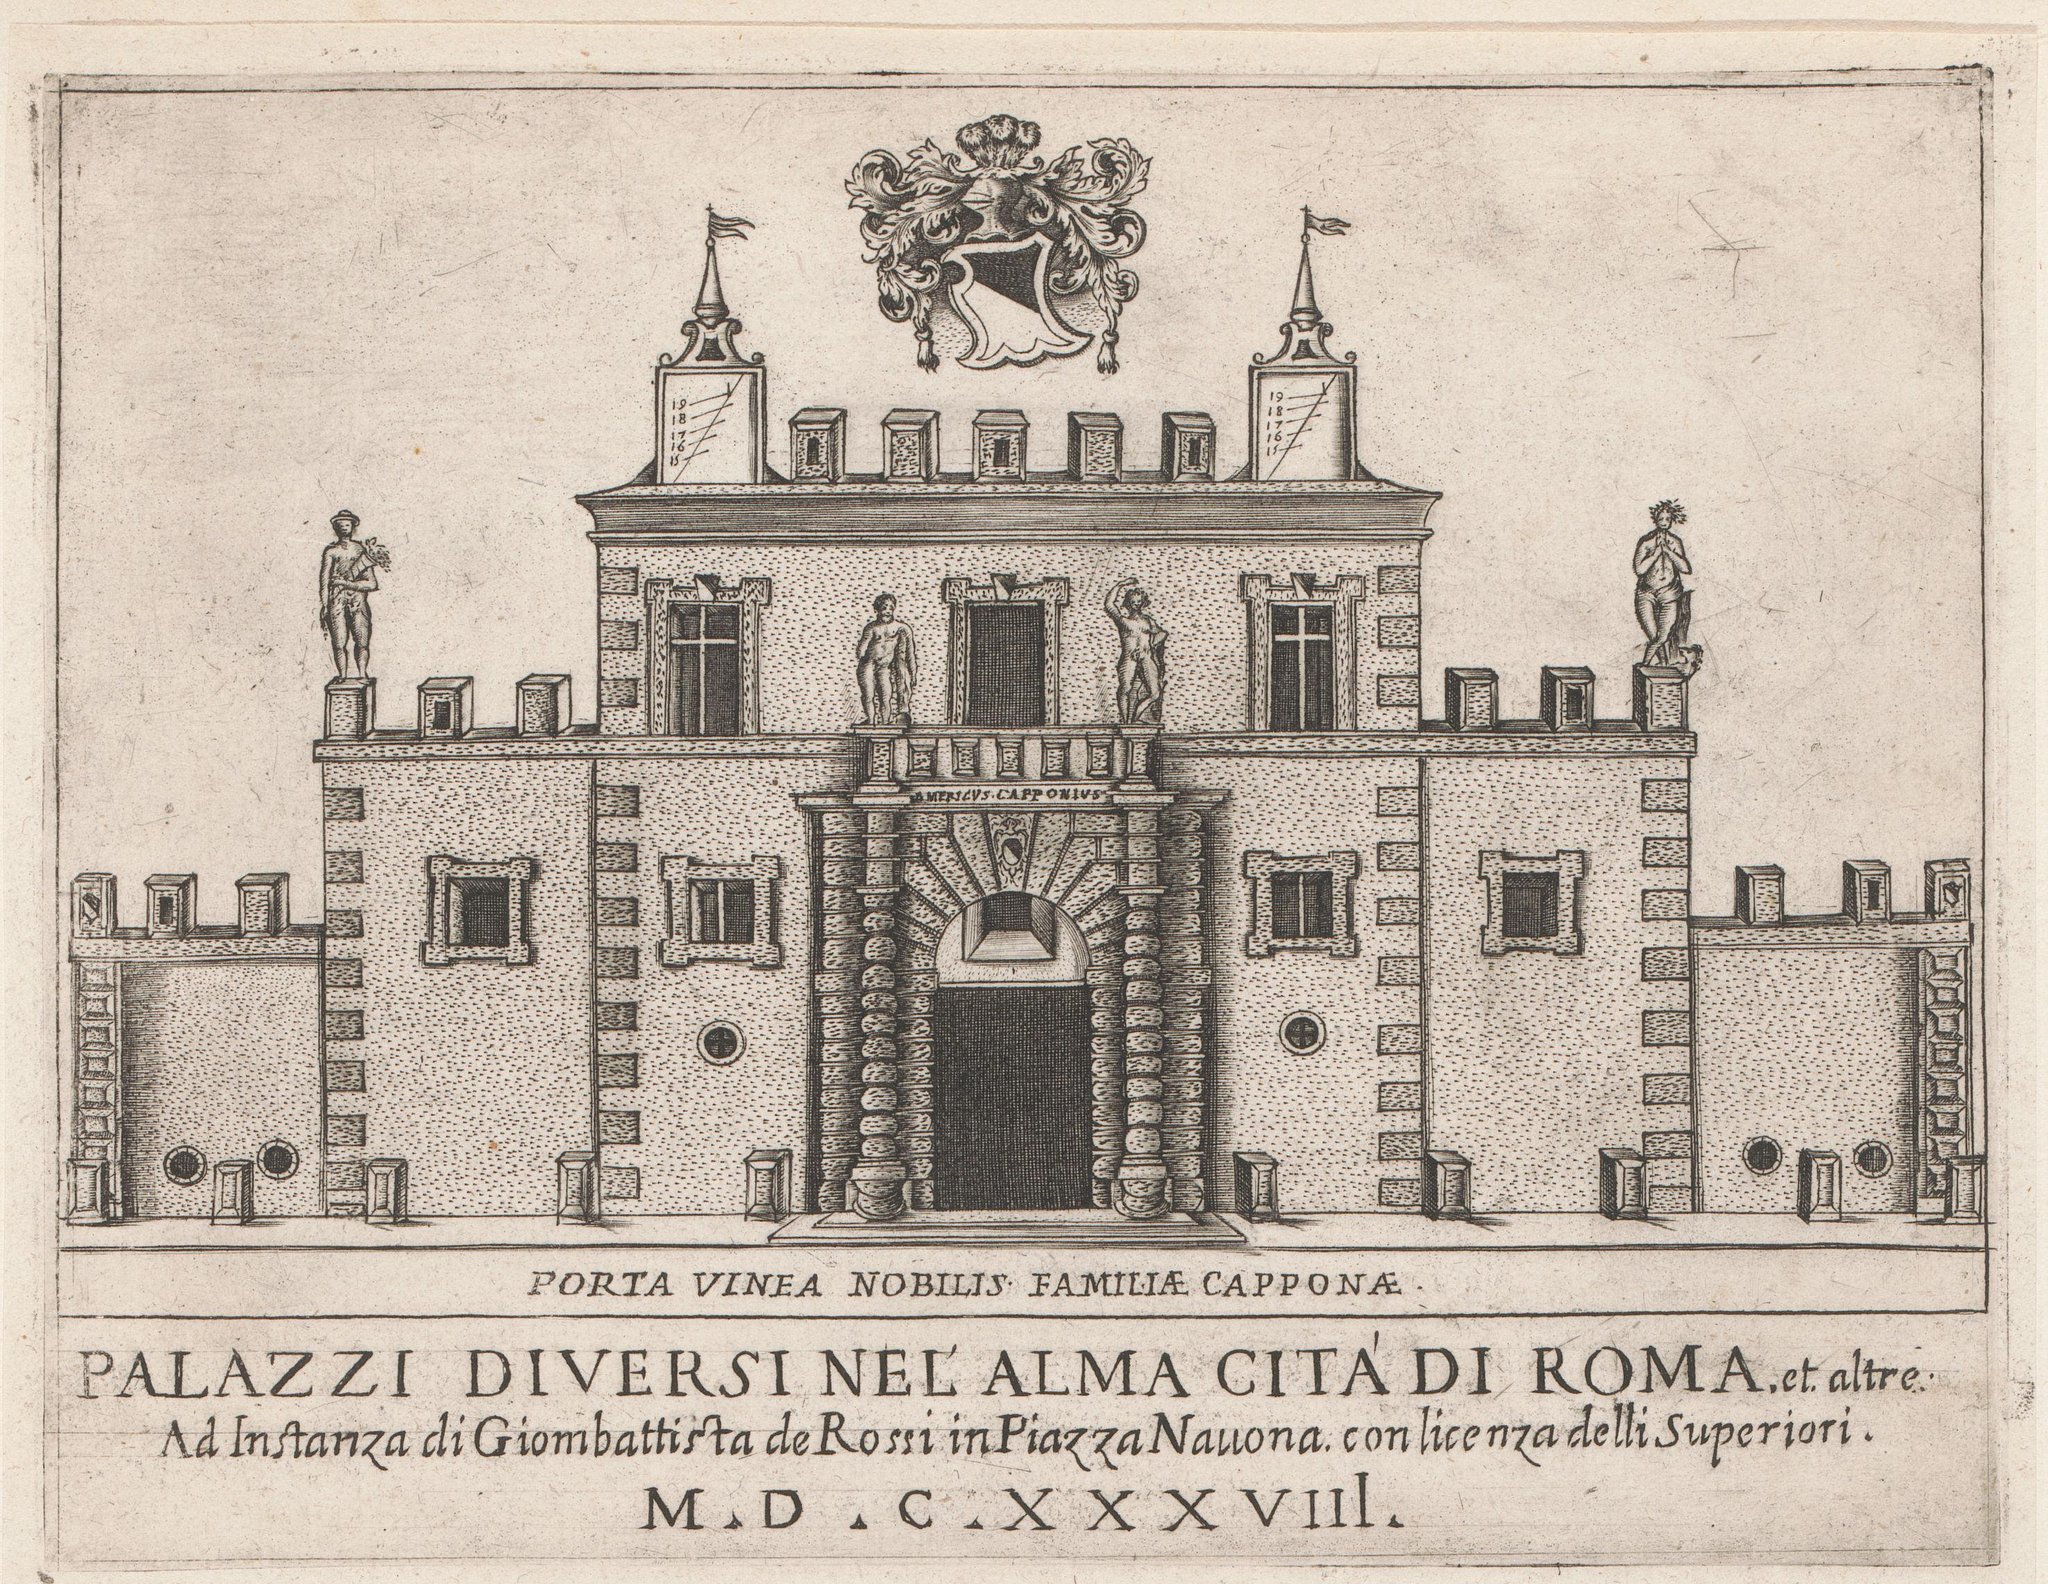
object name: titelprent, frontispice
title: Magesyn der Italiaense gebouwen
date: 1638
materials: paper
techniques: etching, intaglio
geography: italy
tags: city-gate, rome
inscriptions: date